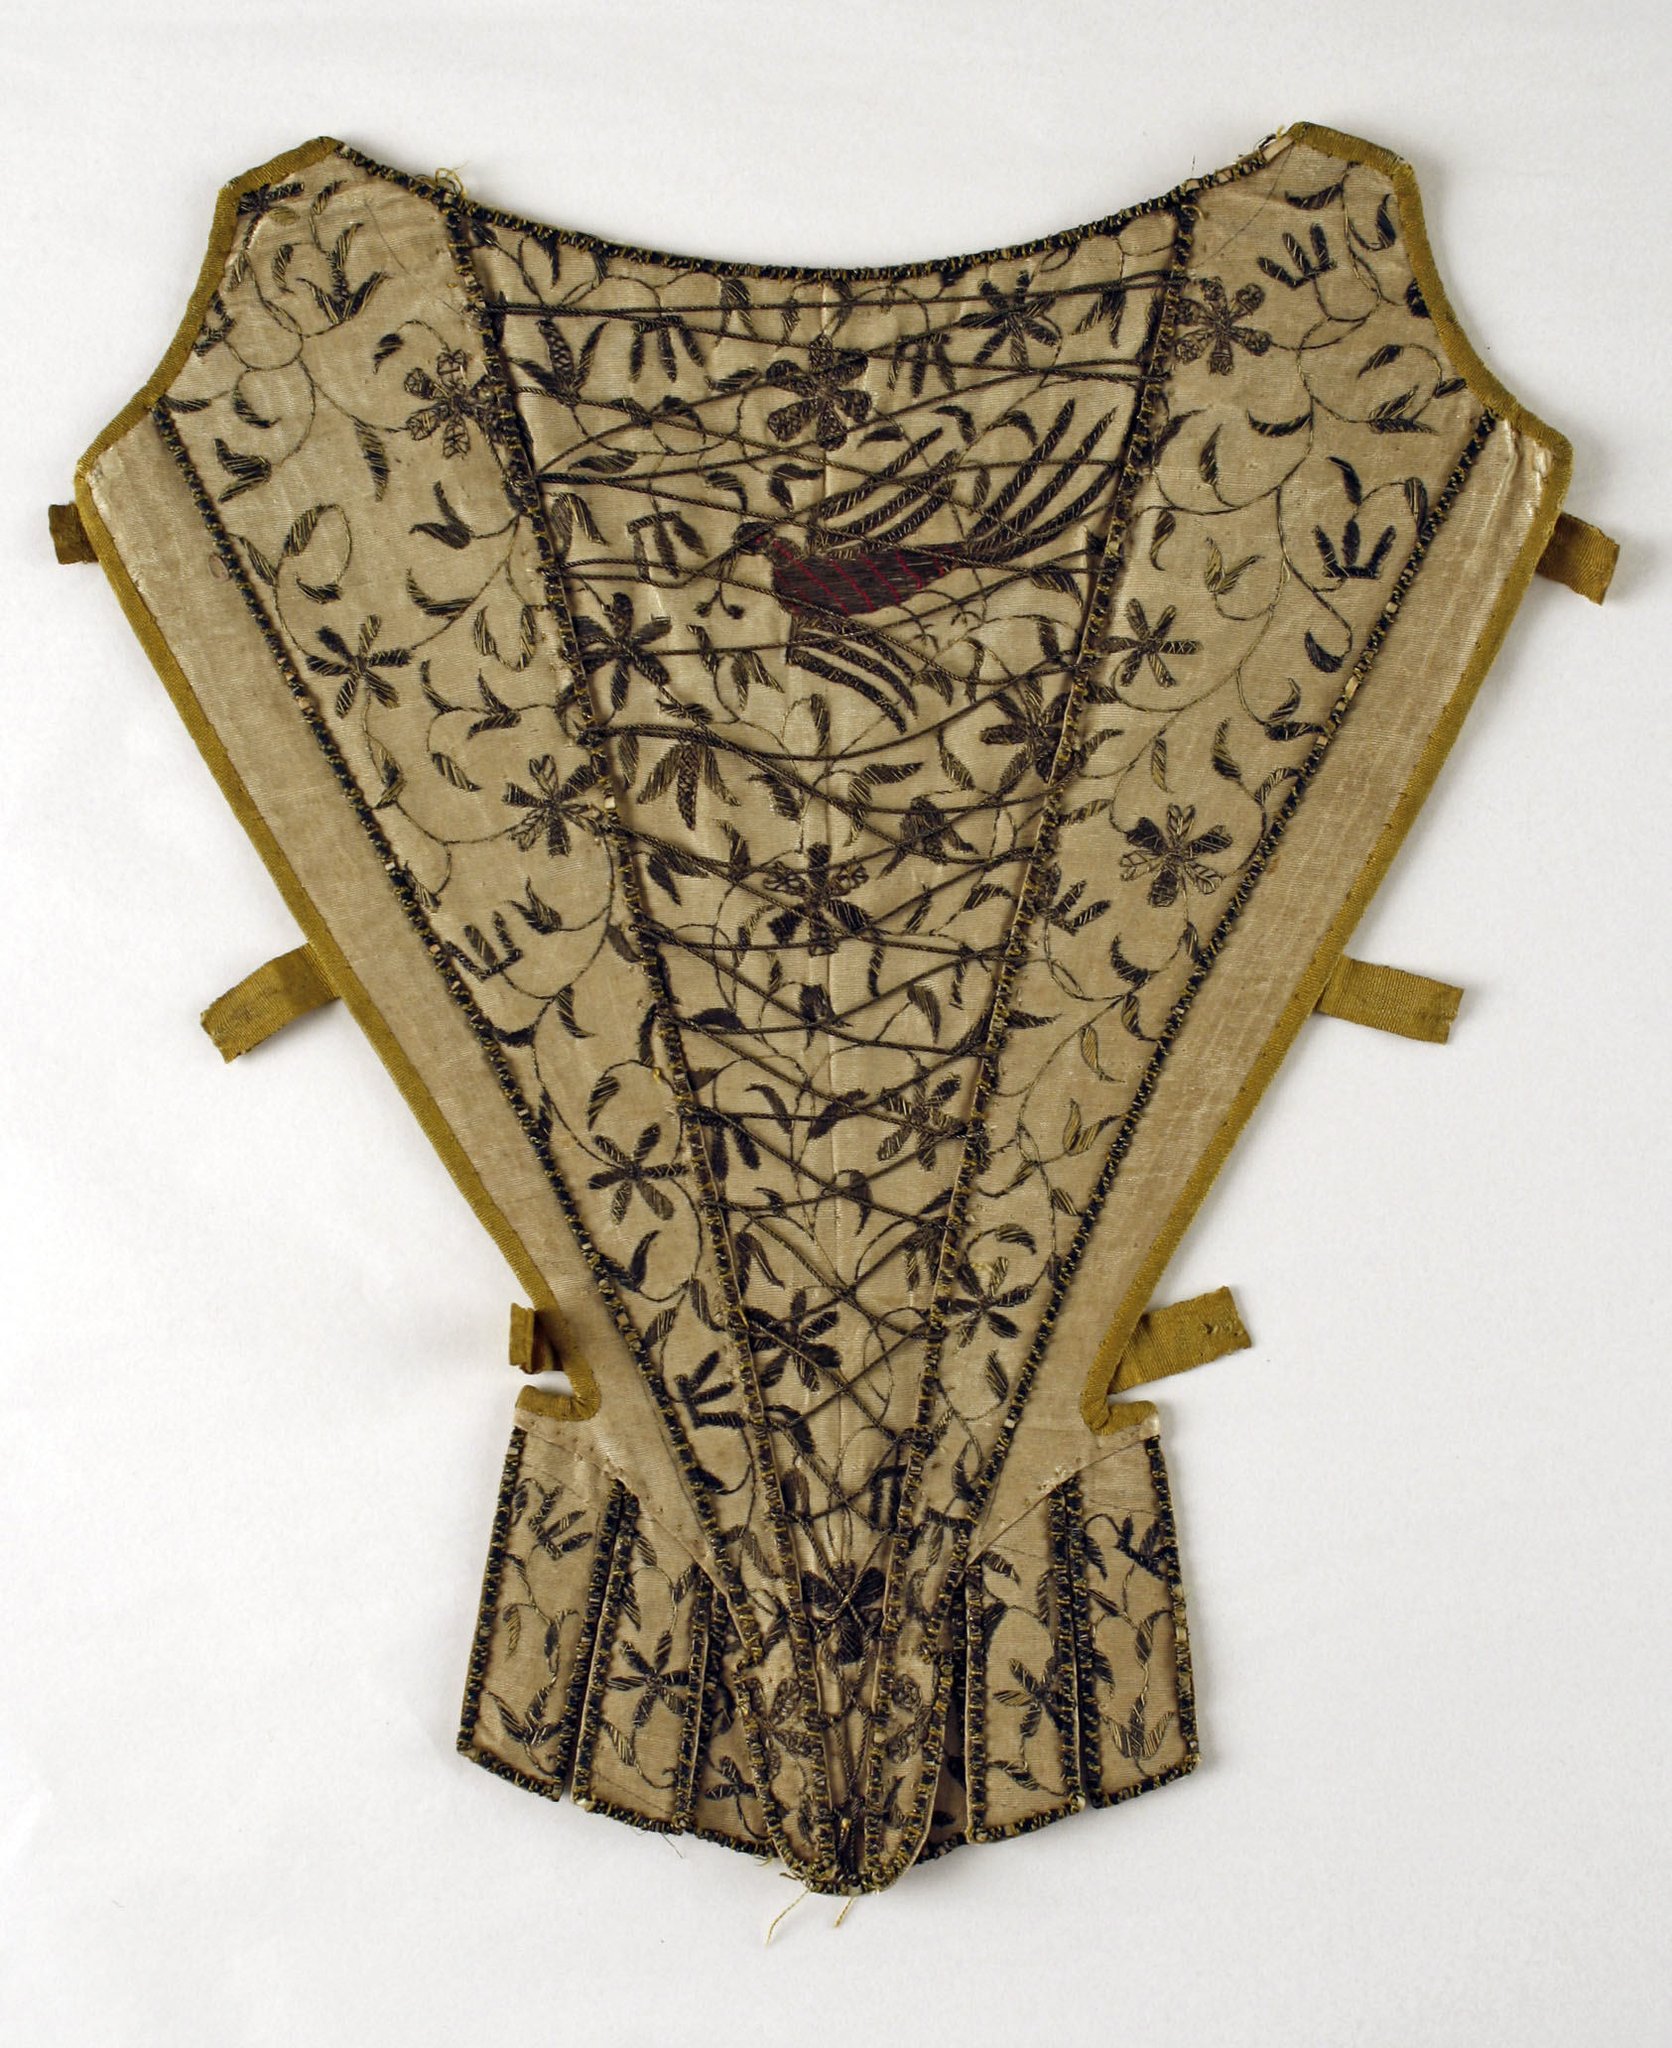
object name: stomacher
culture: british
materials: horn, linen, metal, silk